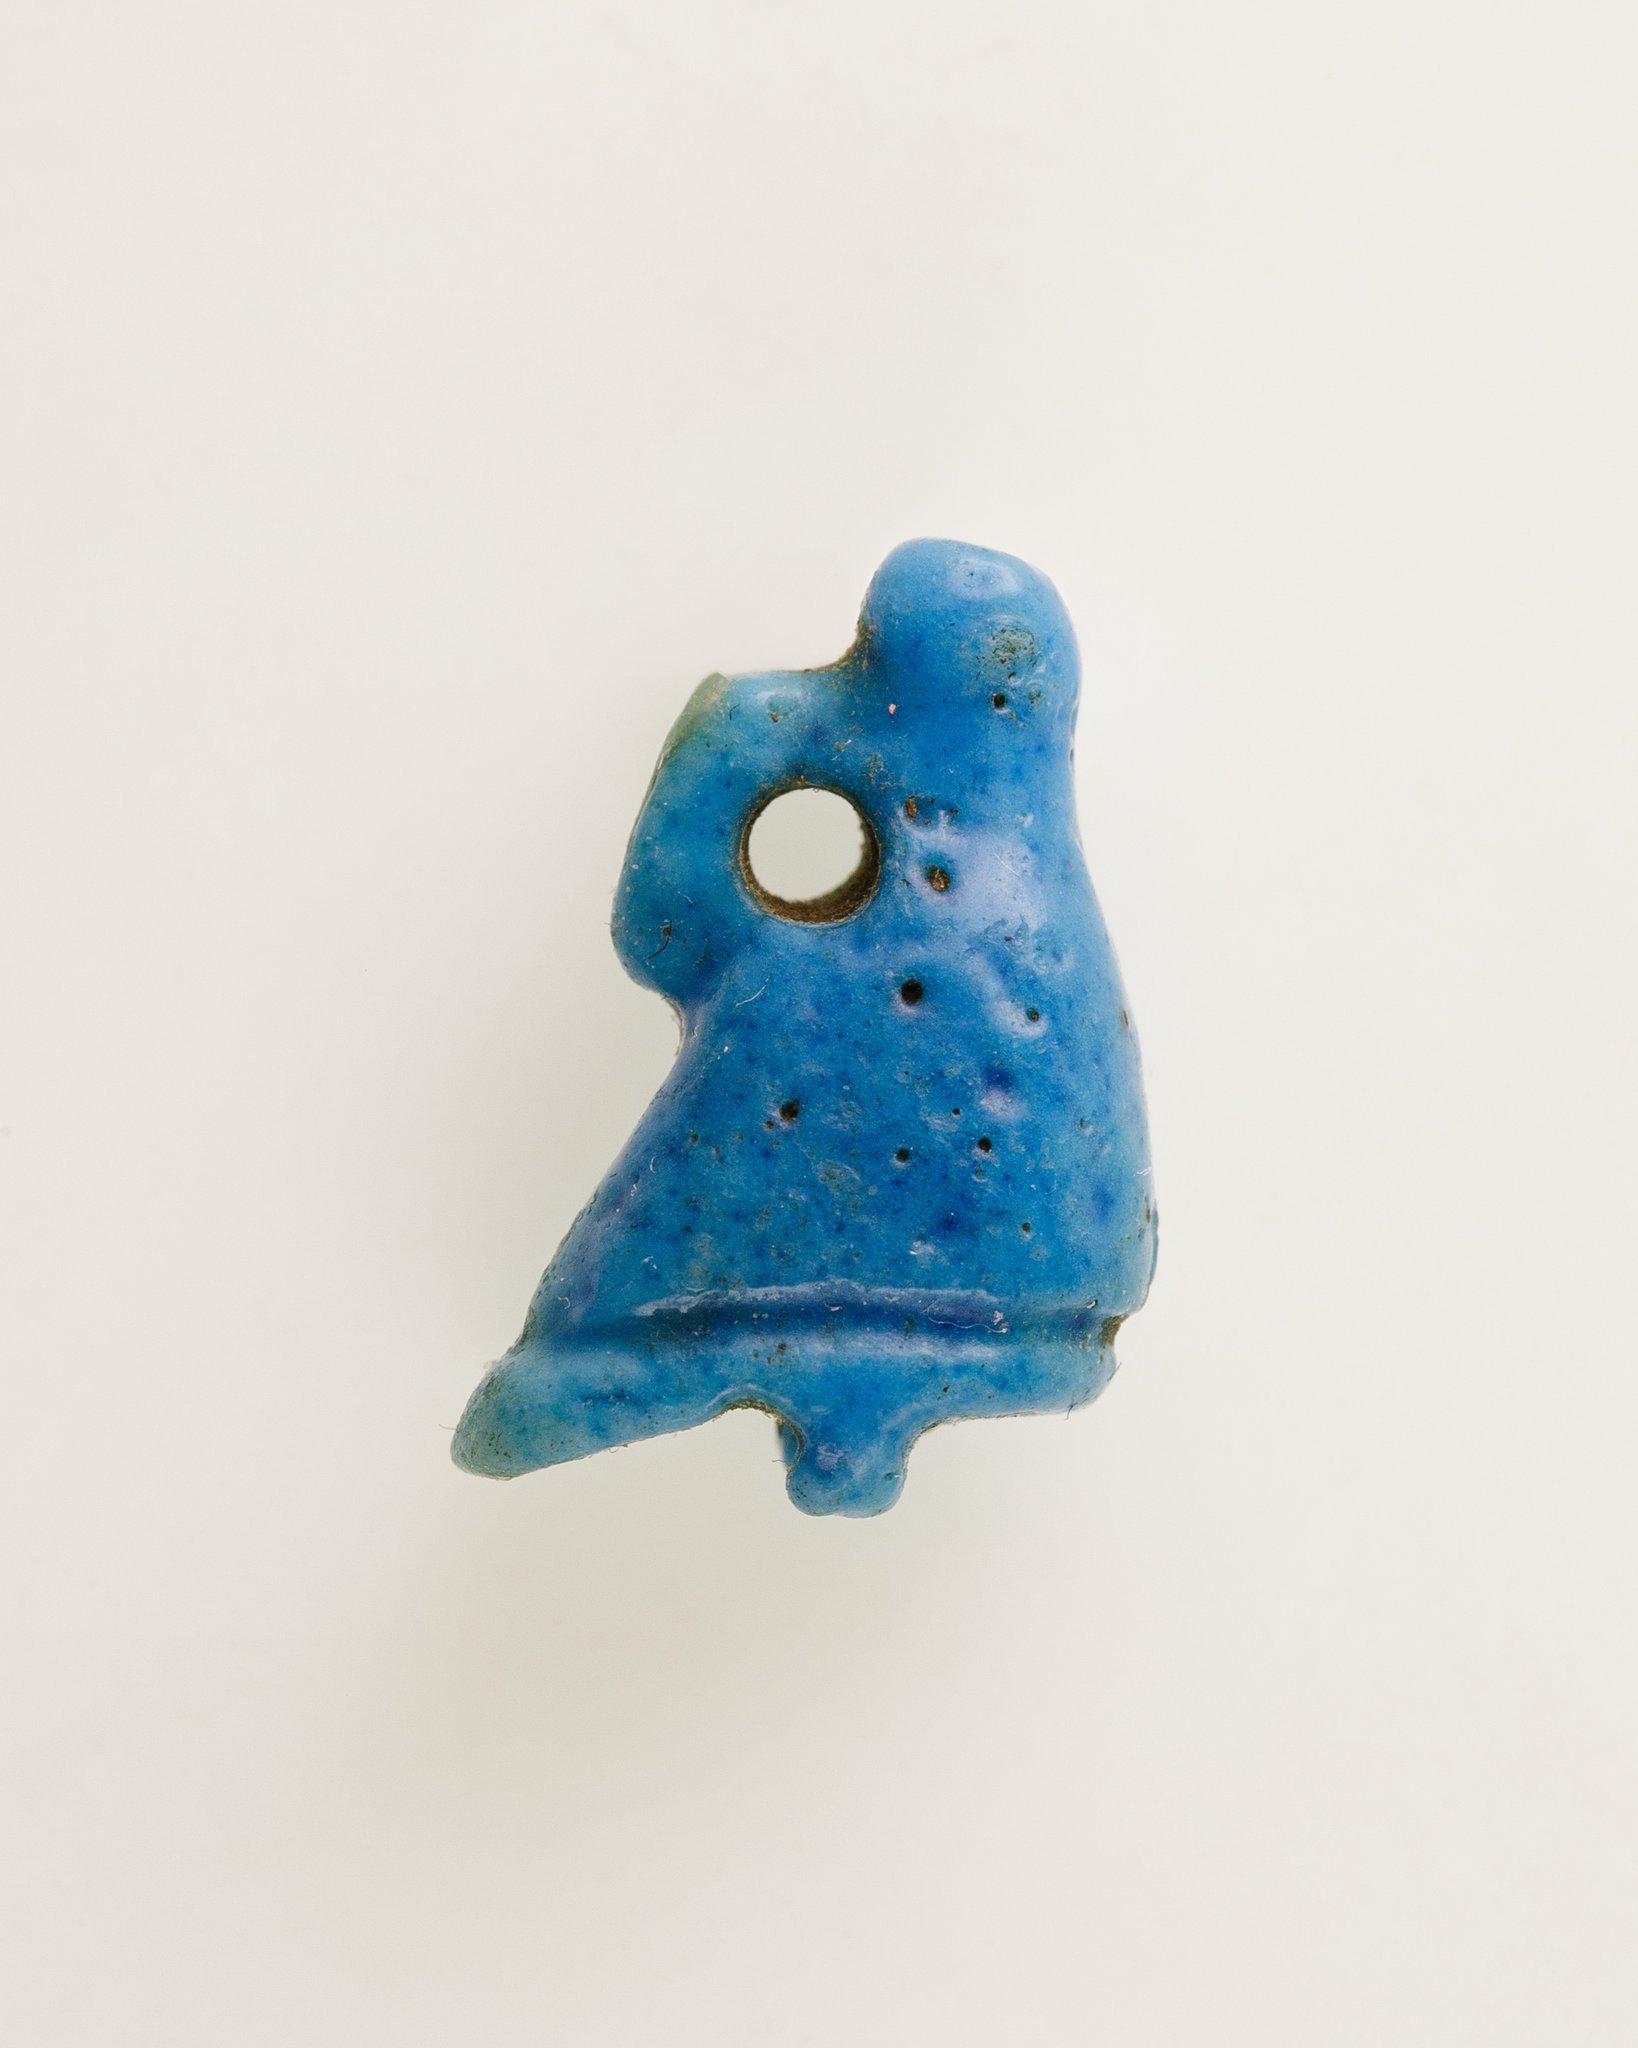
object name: amulet, white crown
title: White Crown amulet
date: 712-332 BCE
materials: faience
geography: egypt